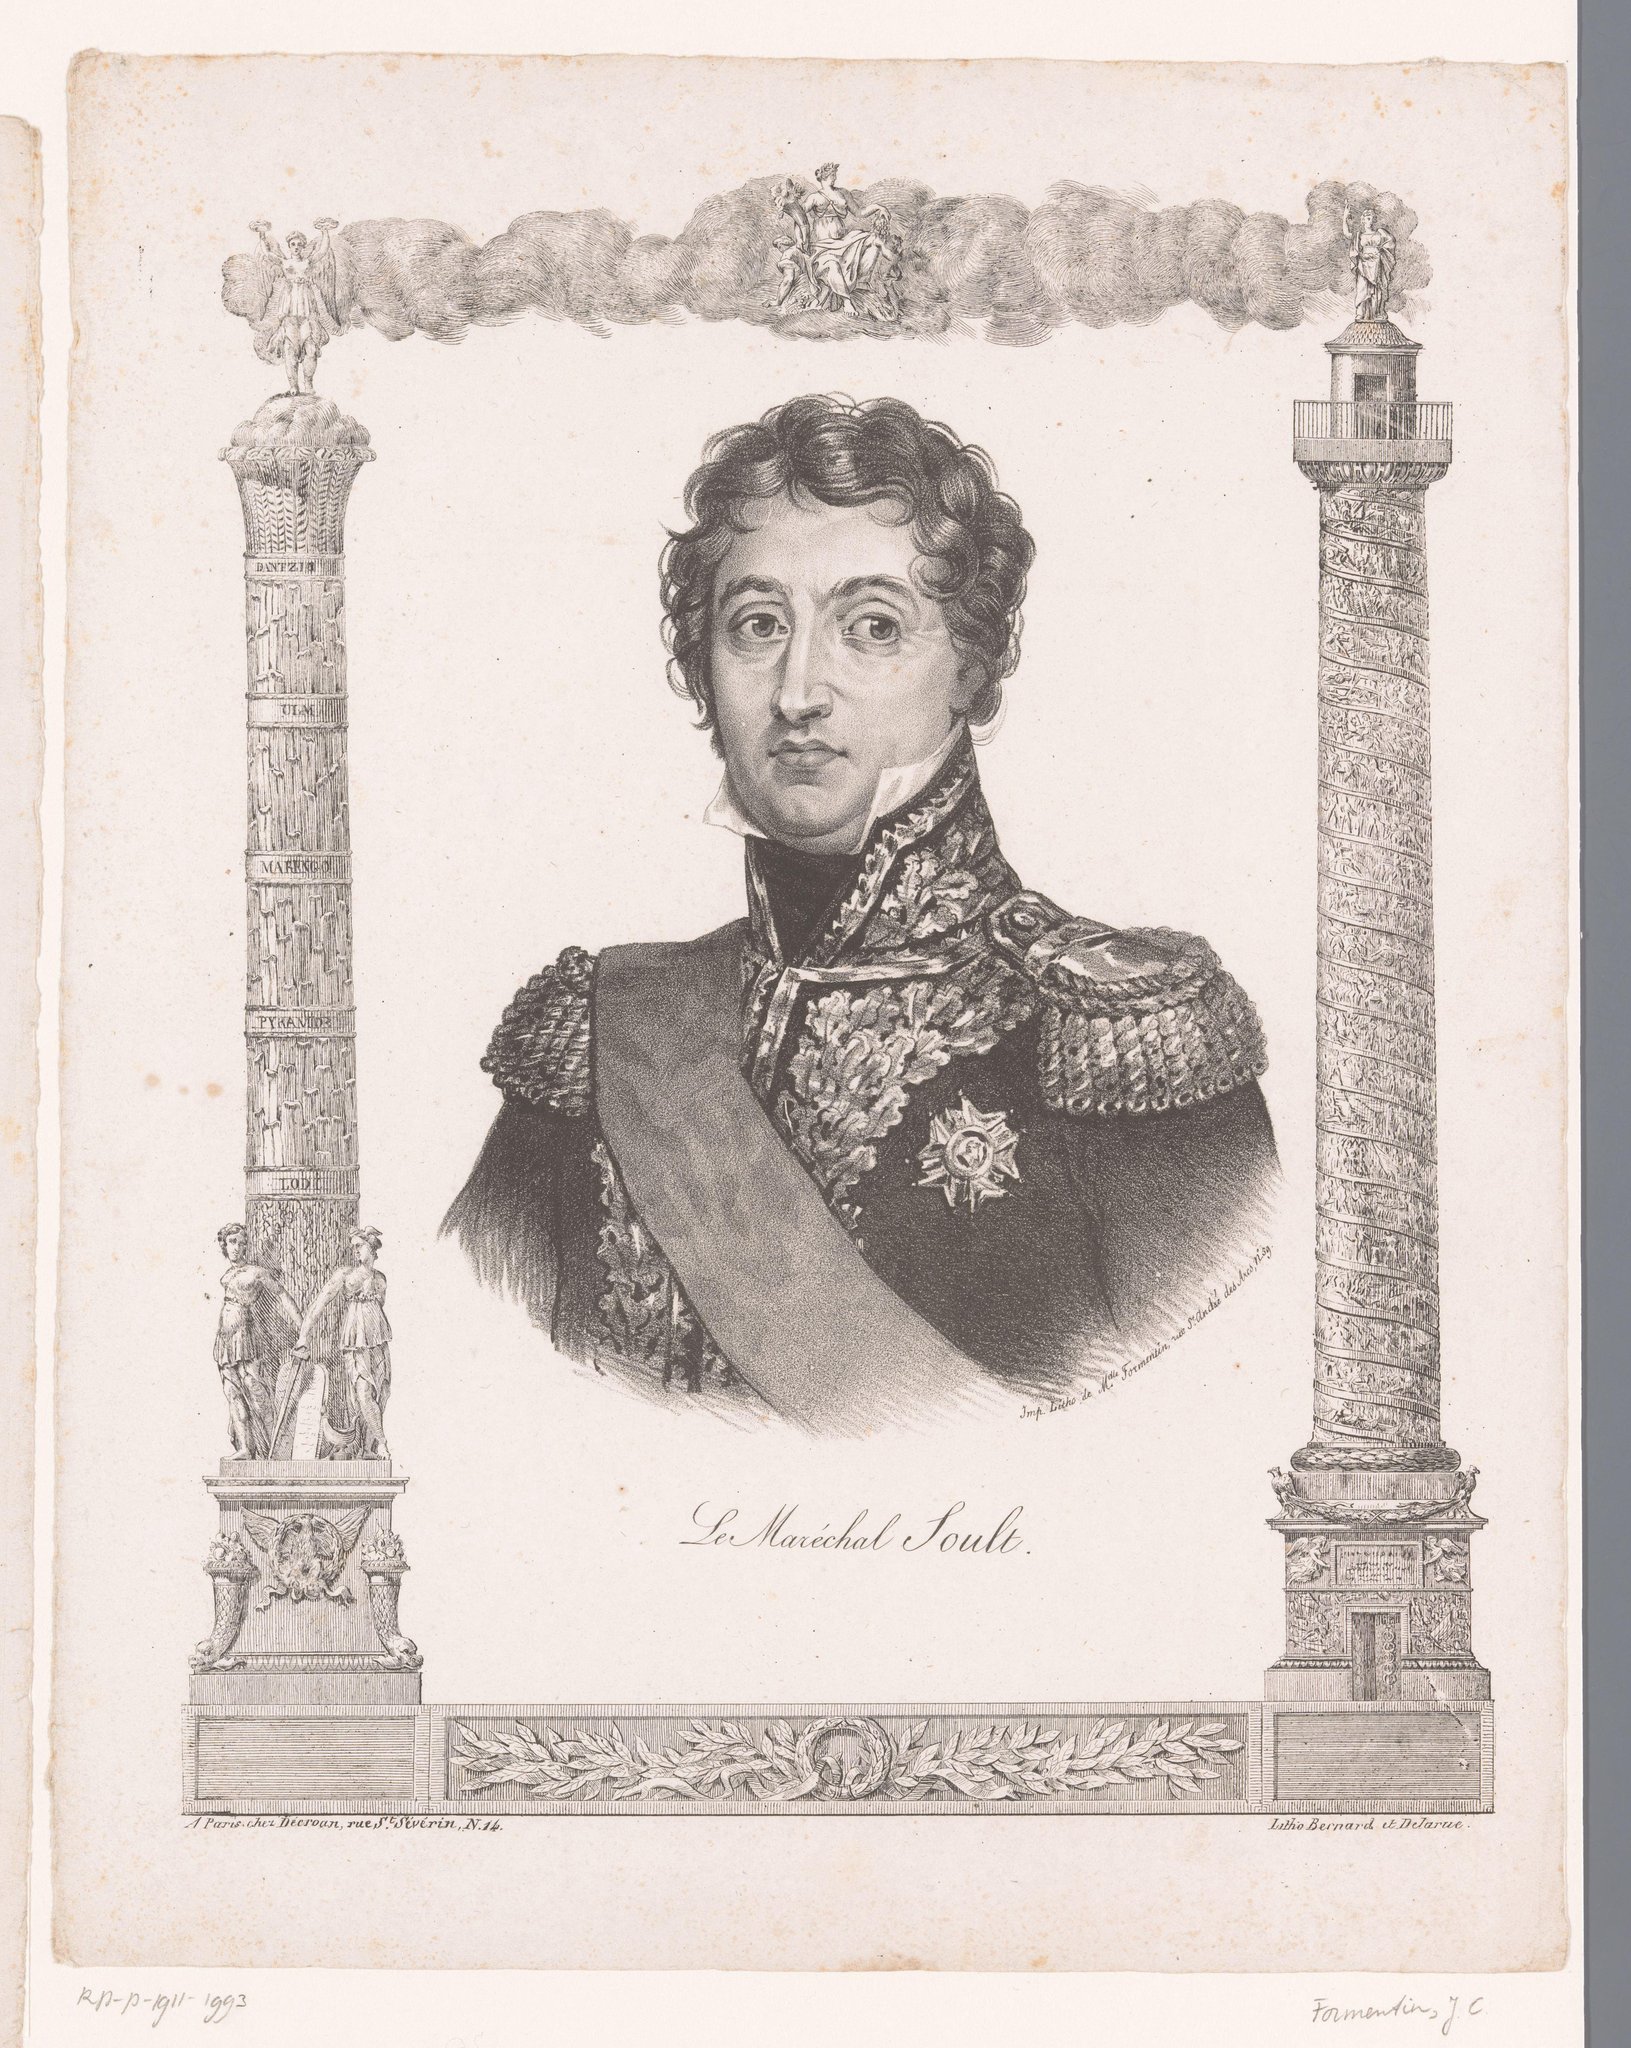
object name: print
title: Portret van Jean-de-Dieu Soult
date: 1826-1829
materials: paper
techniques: lithograph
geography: paris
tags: historical persons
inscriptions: collector's mark: Lugt 2228a